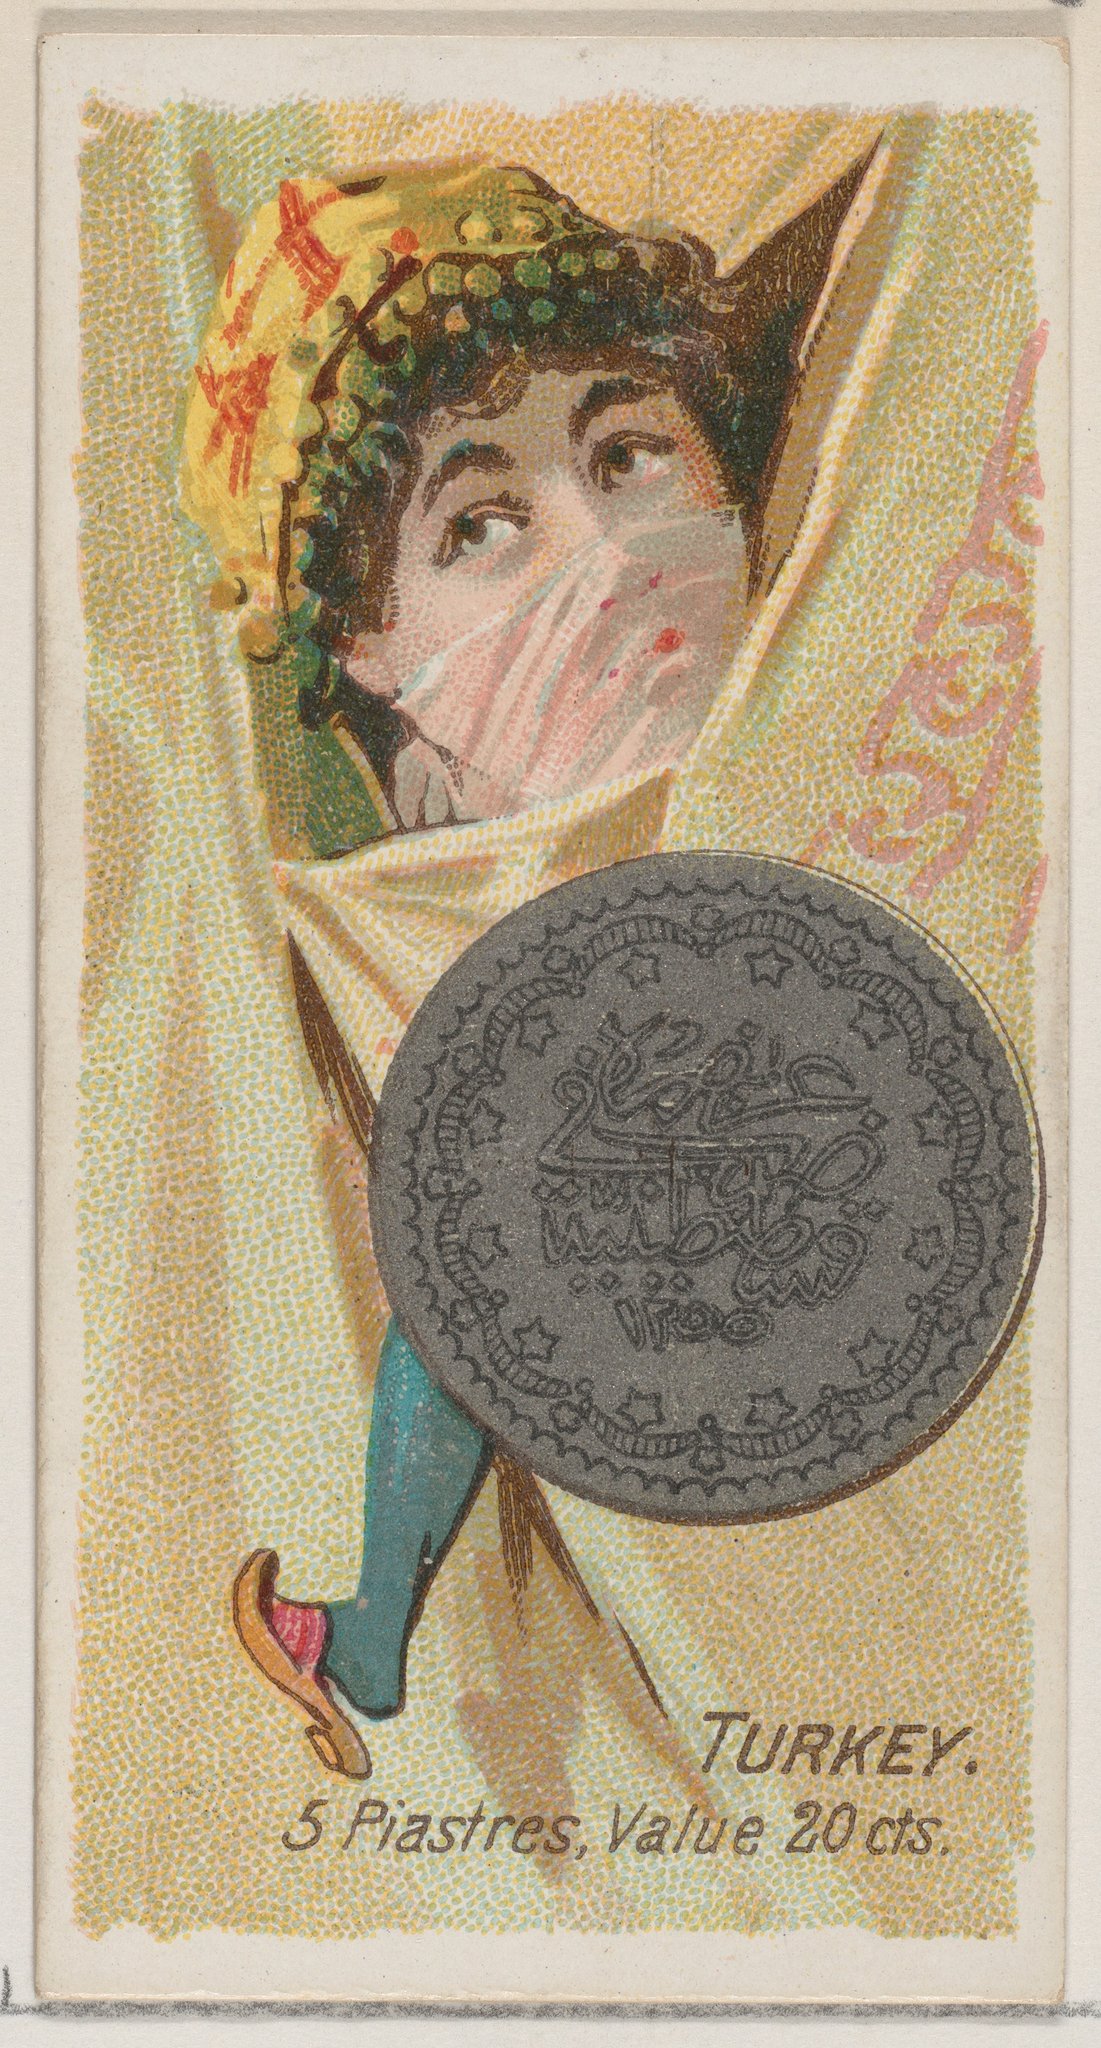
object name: print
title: Turkey, 5 Piastres, from the series Coins of All Nations (N72, variation 2) for Duke brand cigarettes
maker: w. duke, sons & co.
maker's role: publisher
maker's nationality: american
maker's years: 1870-1920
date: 1889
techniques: color lithograph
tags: coins